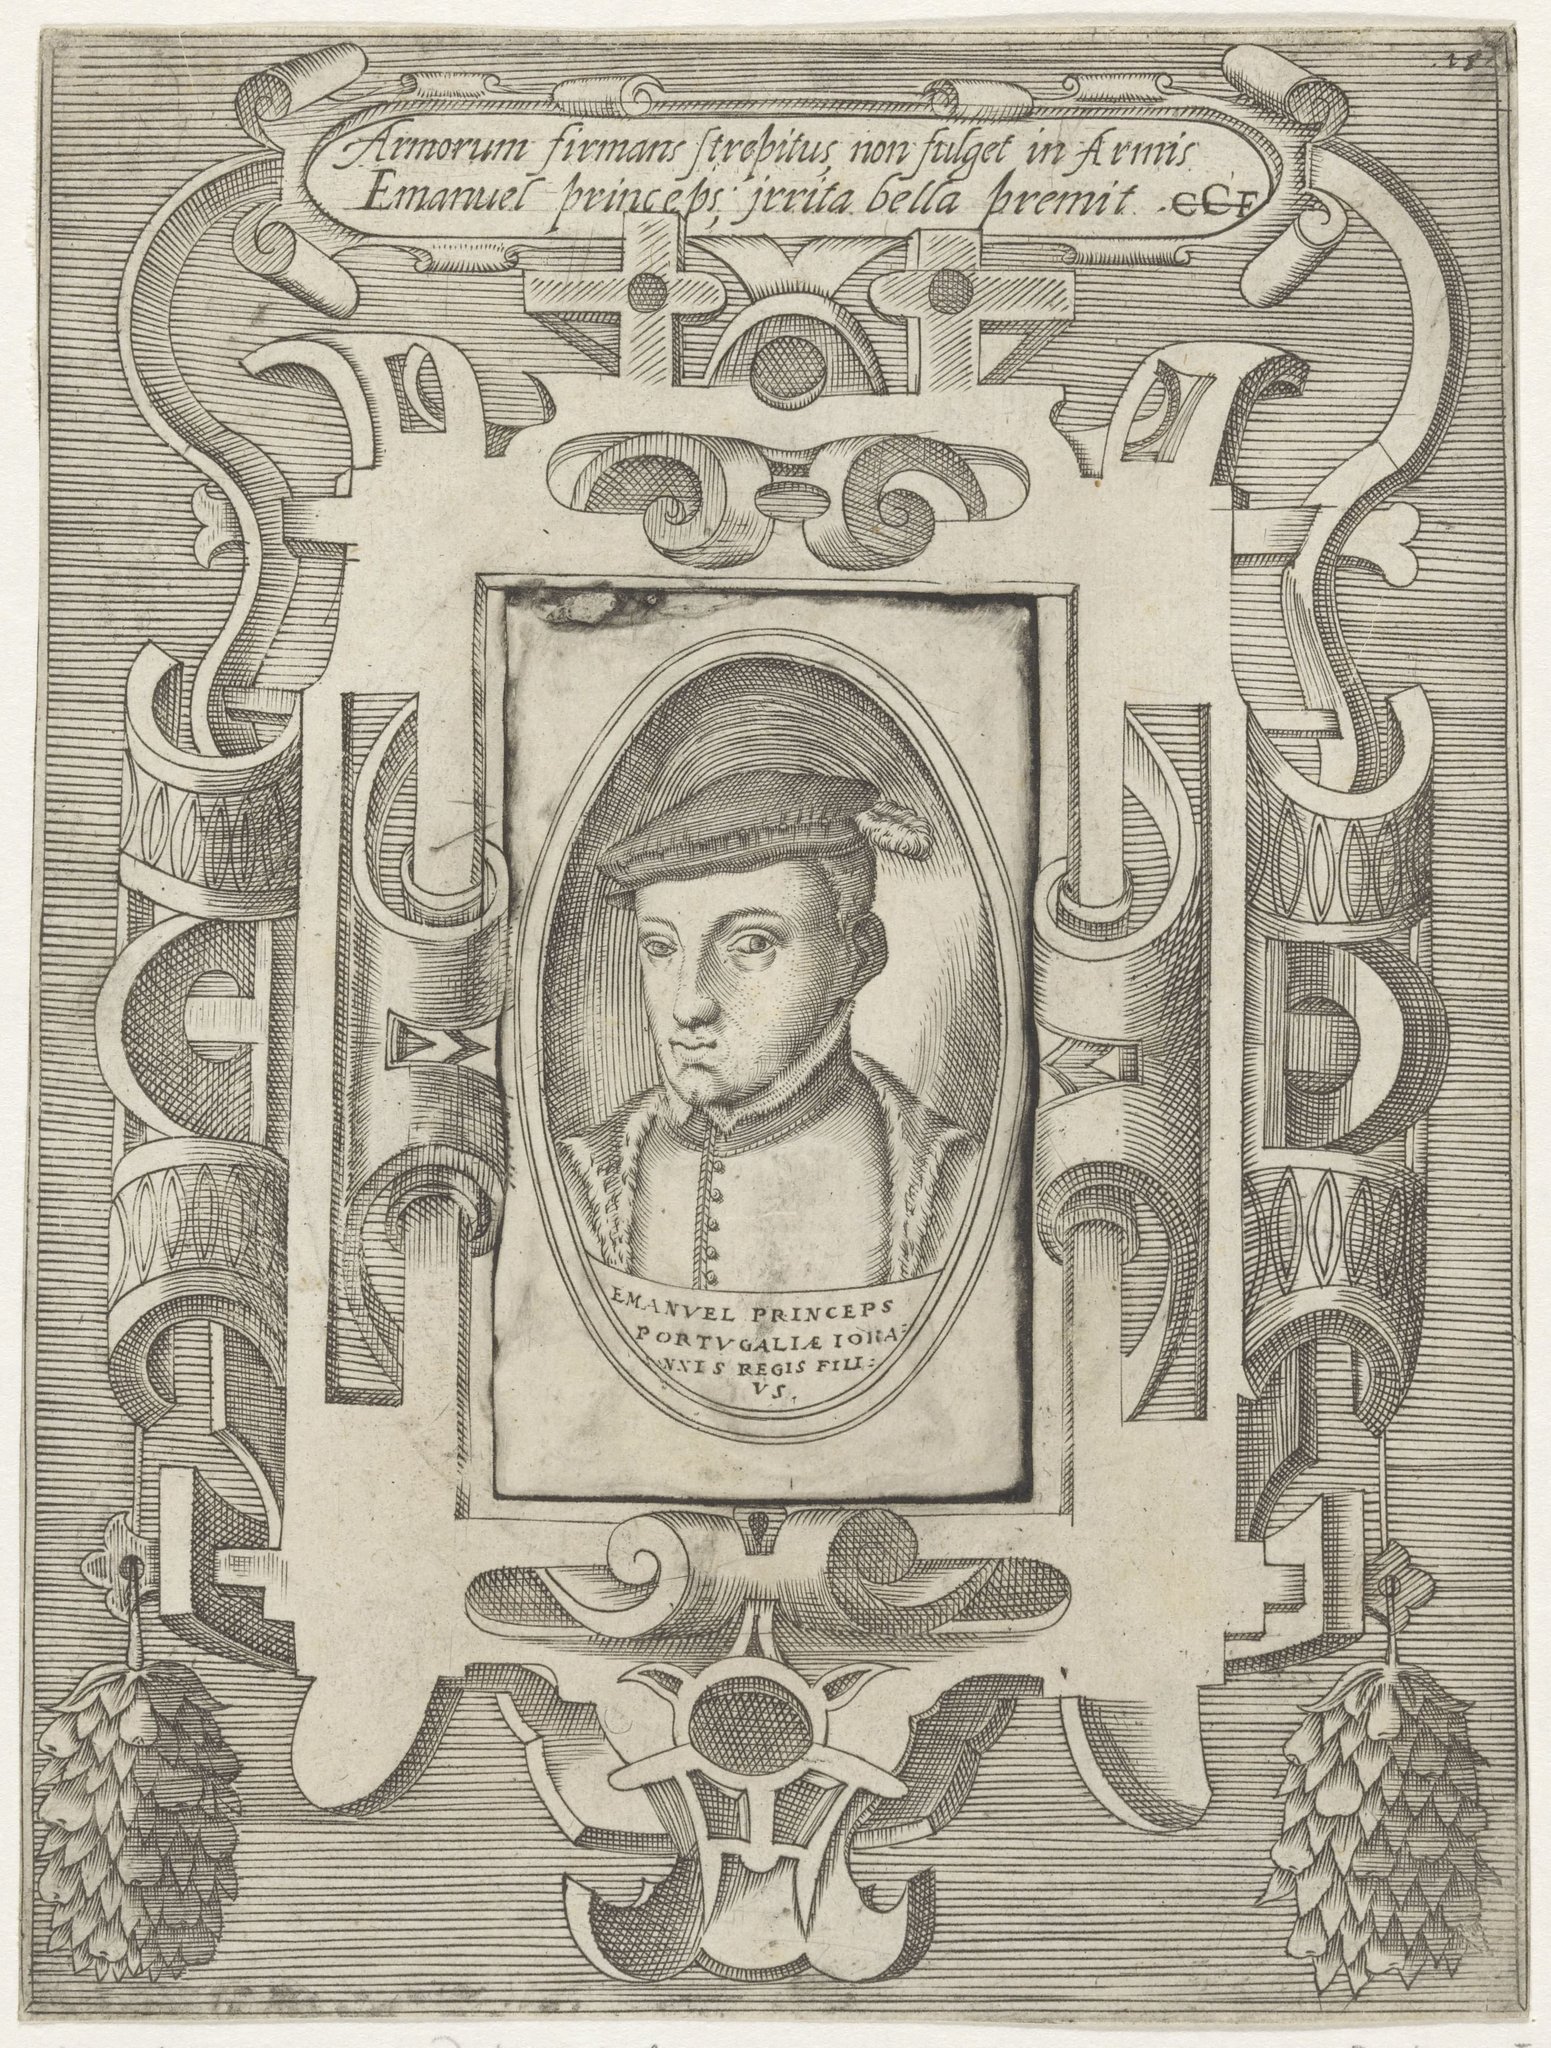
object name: print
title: Portret van Emanuel I, koning van Portugal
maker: camillo cungi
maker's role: print maker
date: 1597-1649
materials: paper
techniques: engraving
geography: italy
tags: historical persons, ruler, sovereign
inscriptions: collector's mark: Lugt 2228